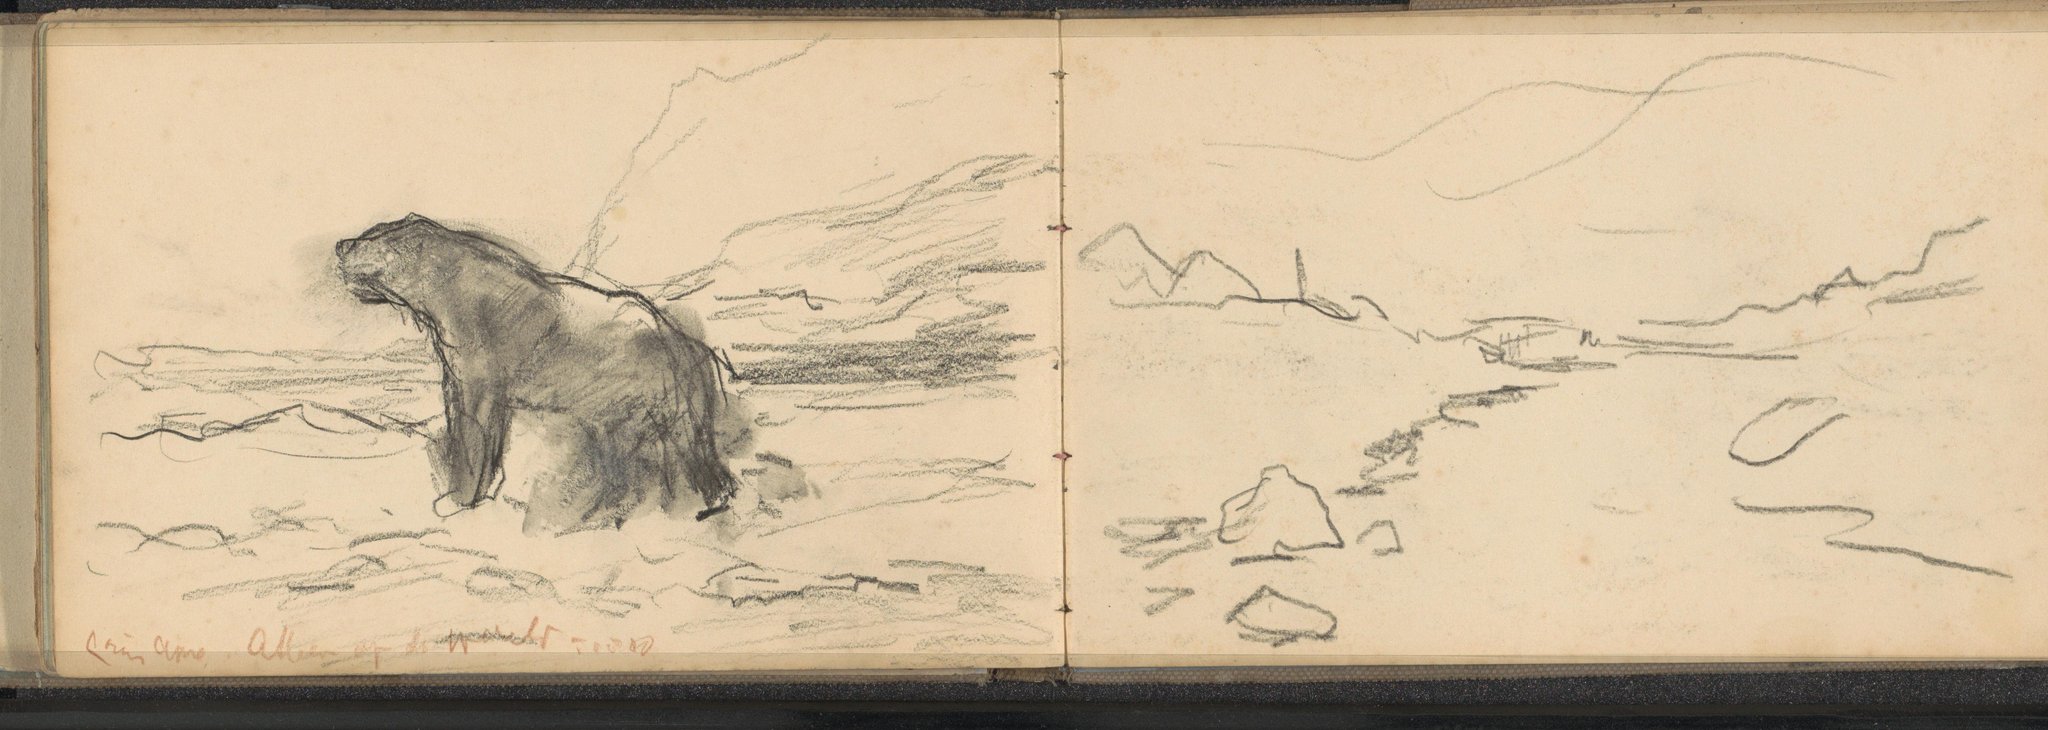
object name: sketchbook leaf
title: Landschap, mogelijk bij Hammerfest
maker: louis apol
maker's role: draughtsman, painter, print maker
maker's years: 1850-1936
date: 1880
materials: chalk, paper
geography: norway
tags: landscapes in polar regions, norway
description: Blad 31 recto uit een schetsboek met 38 bladen betekend tijdens de expeditie naar Nova Zembla in 1880.